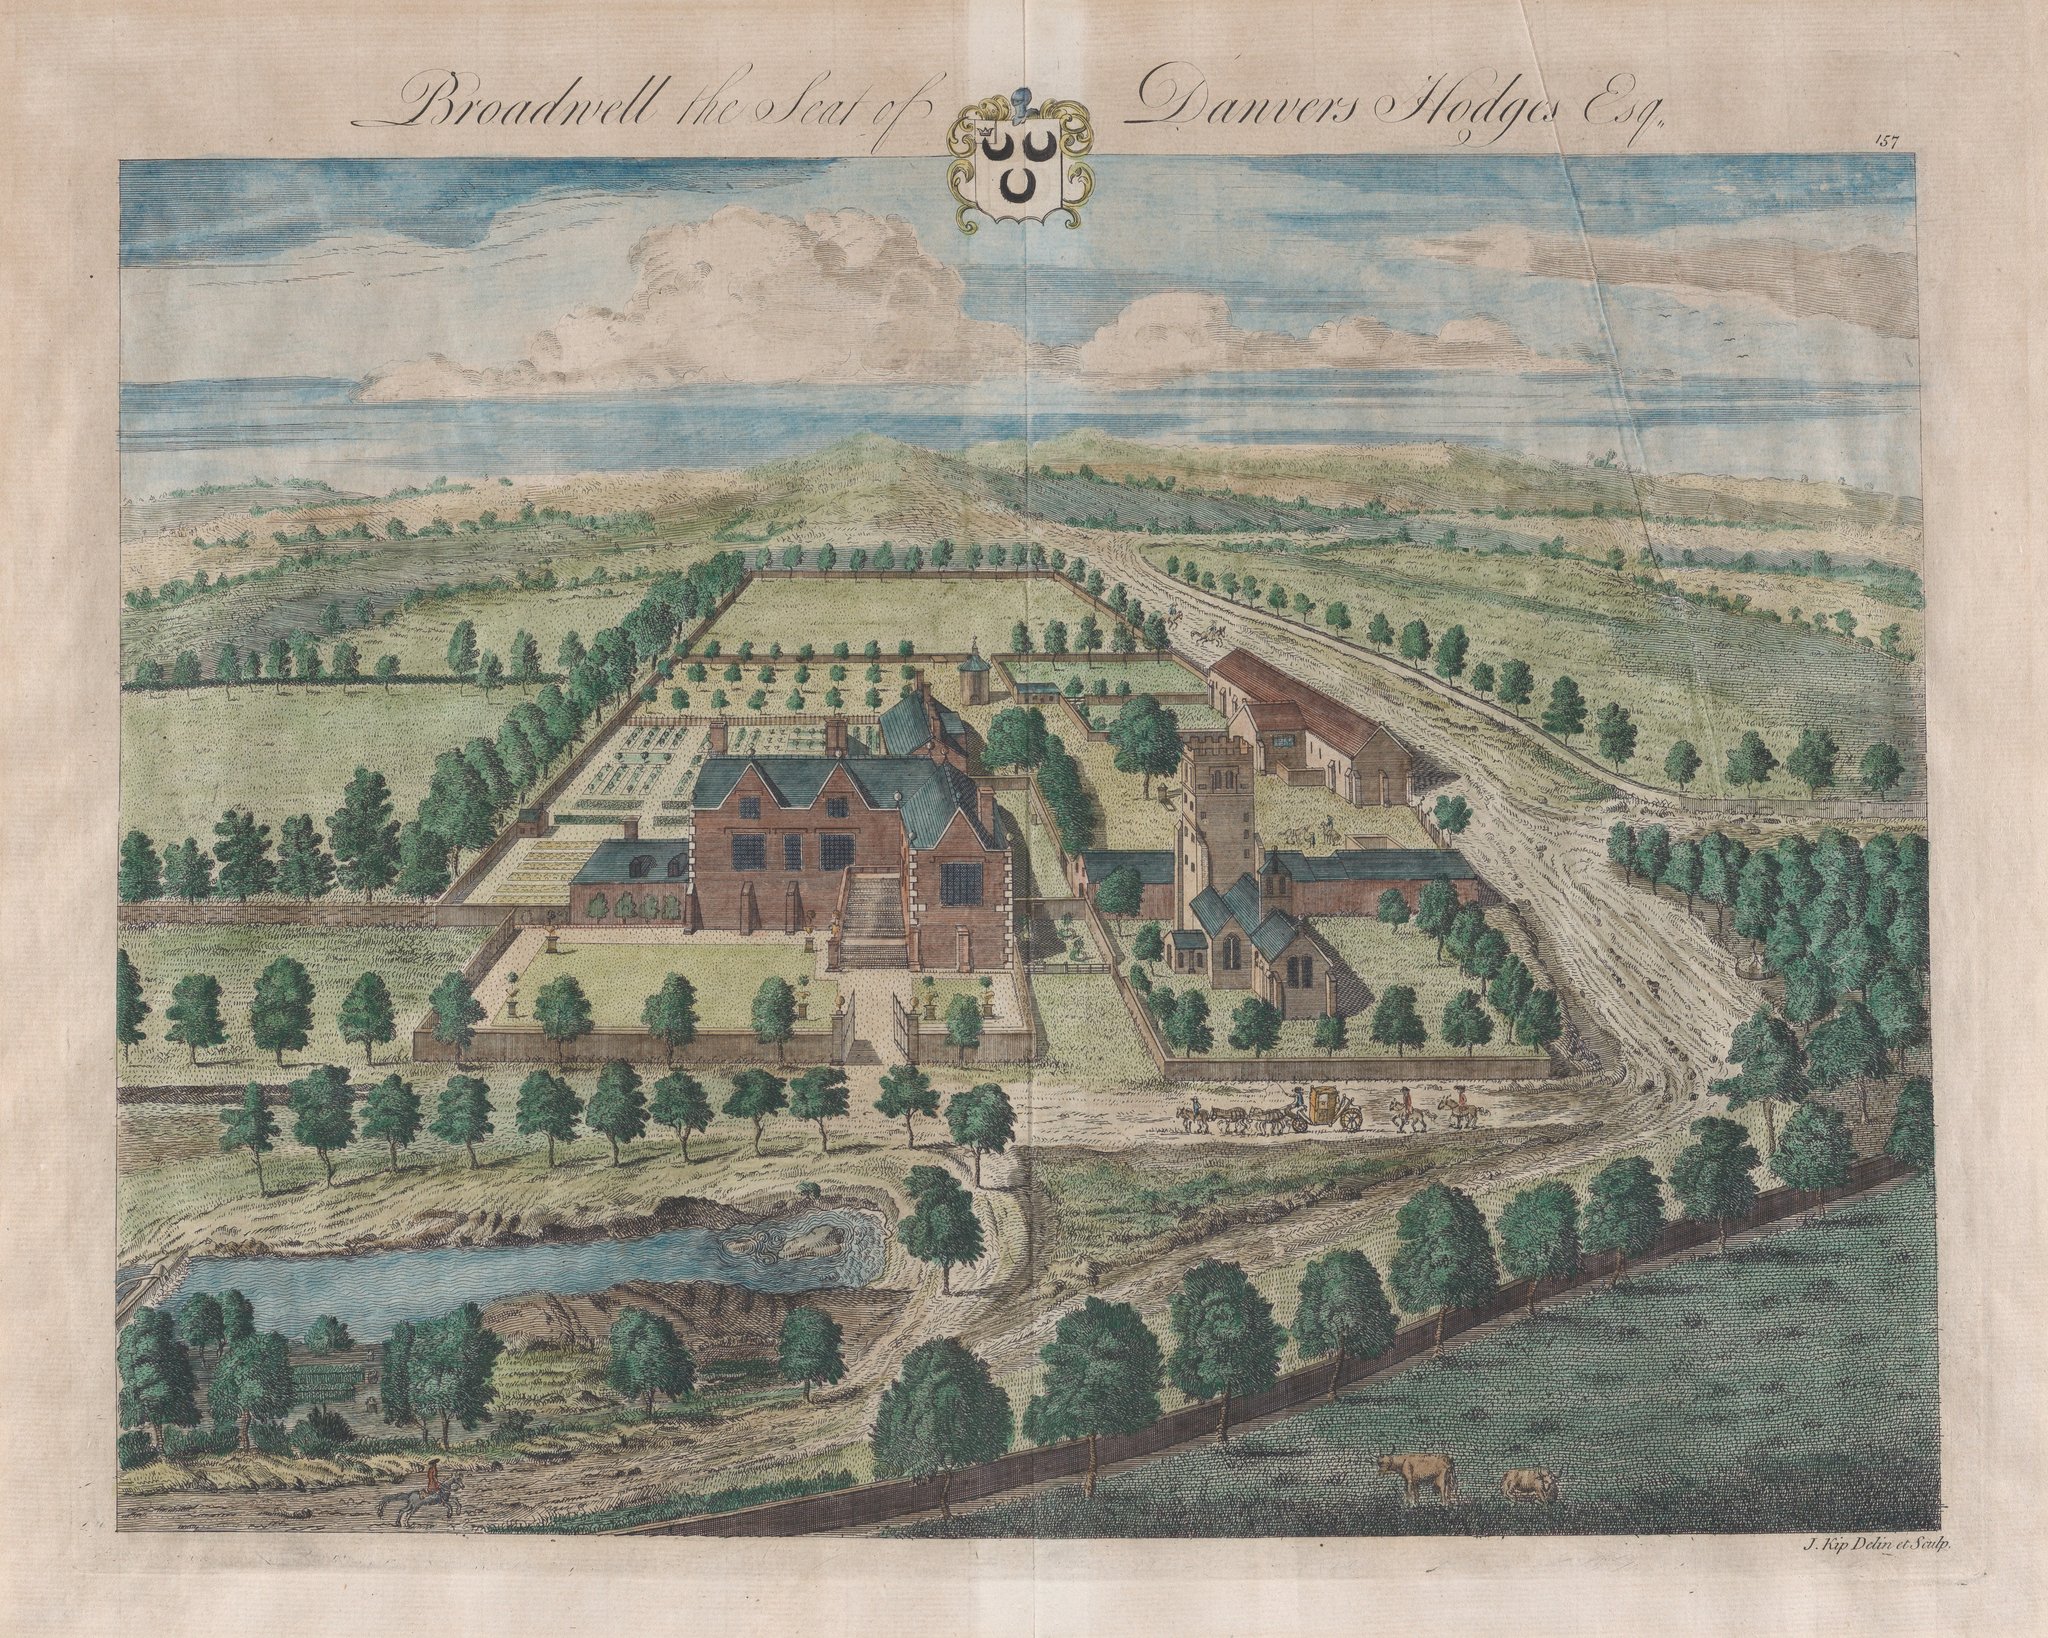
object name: print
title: Broadwell, The Seat of Danvers Hodges, plate 157 from "The Ancient and Present State of Gloucestershire"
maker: johannes kip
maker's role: artist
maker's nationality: dutch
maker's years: 1653-1722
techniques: engraving, etching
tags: houses,gardens,landscapes,coat of arms